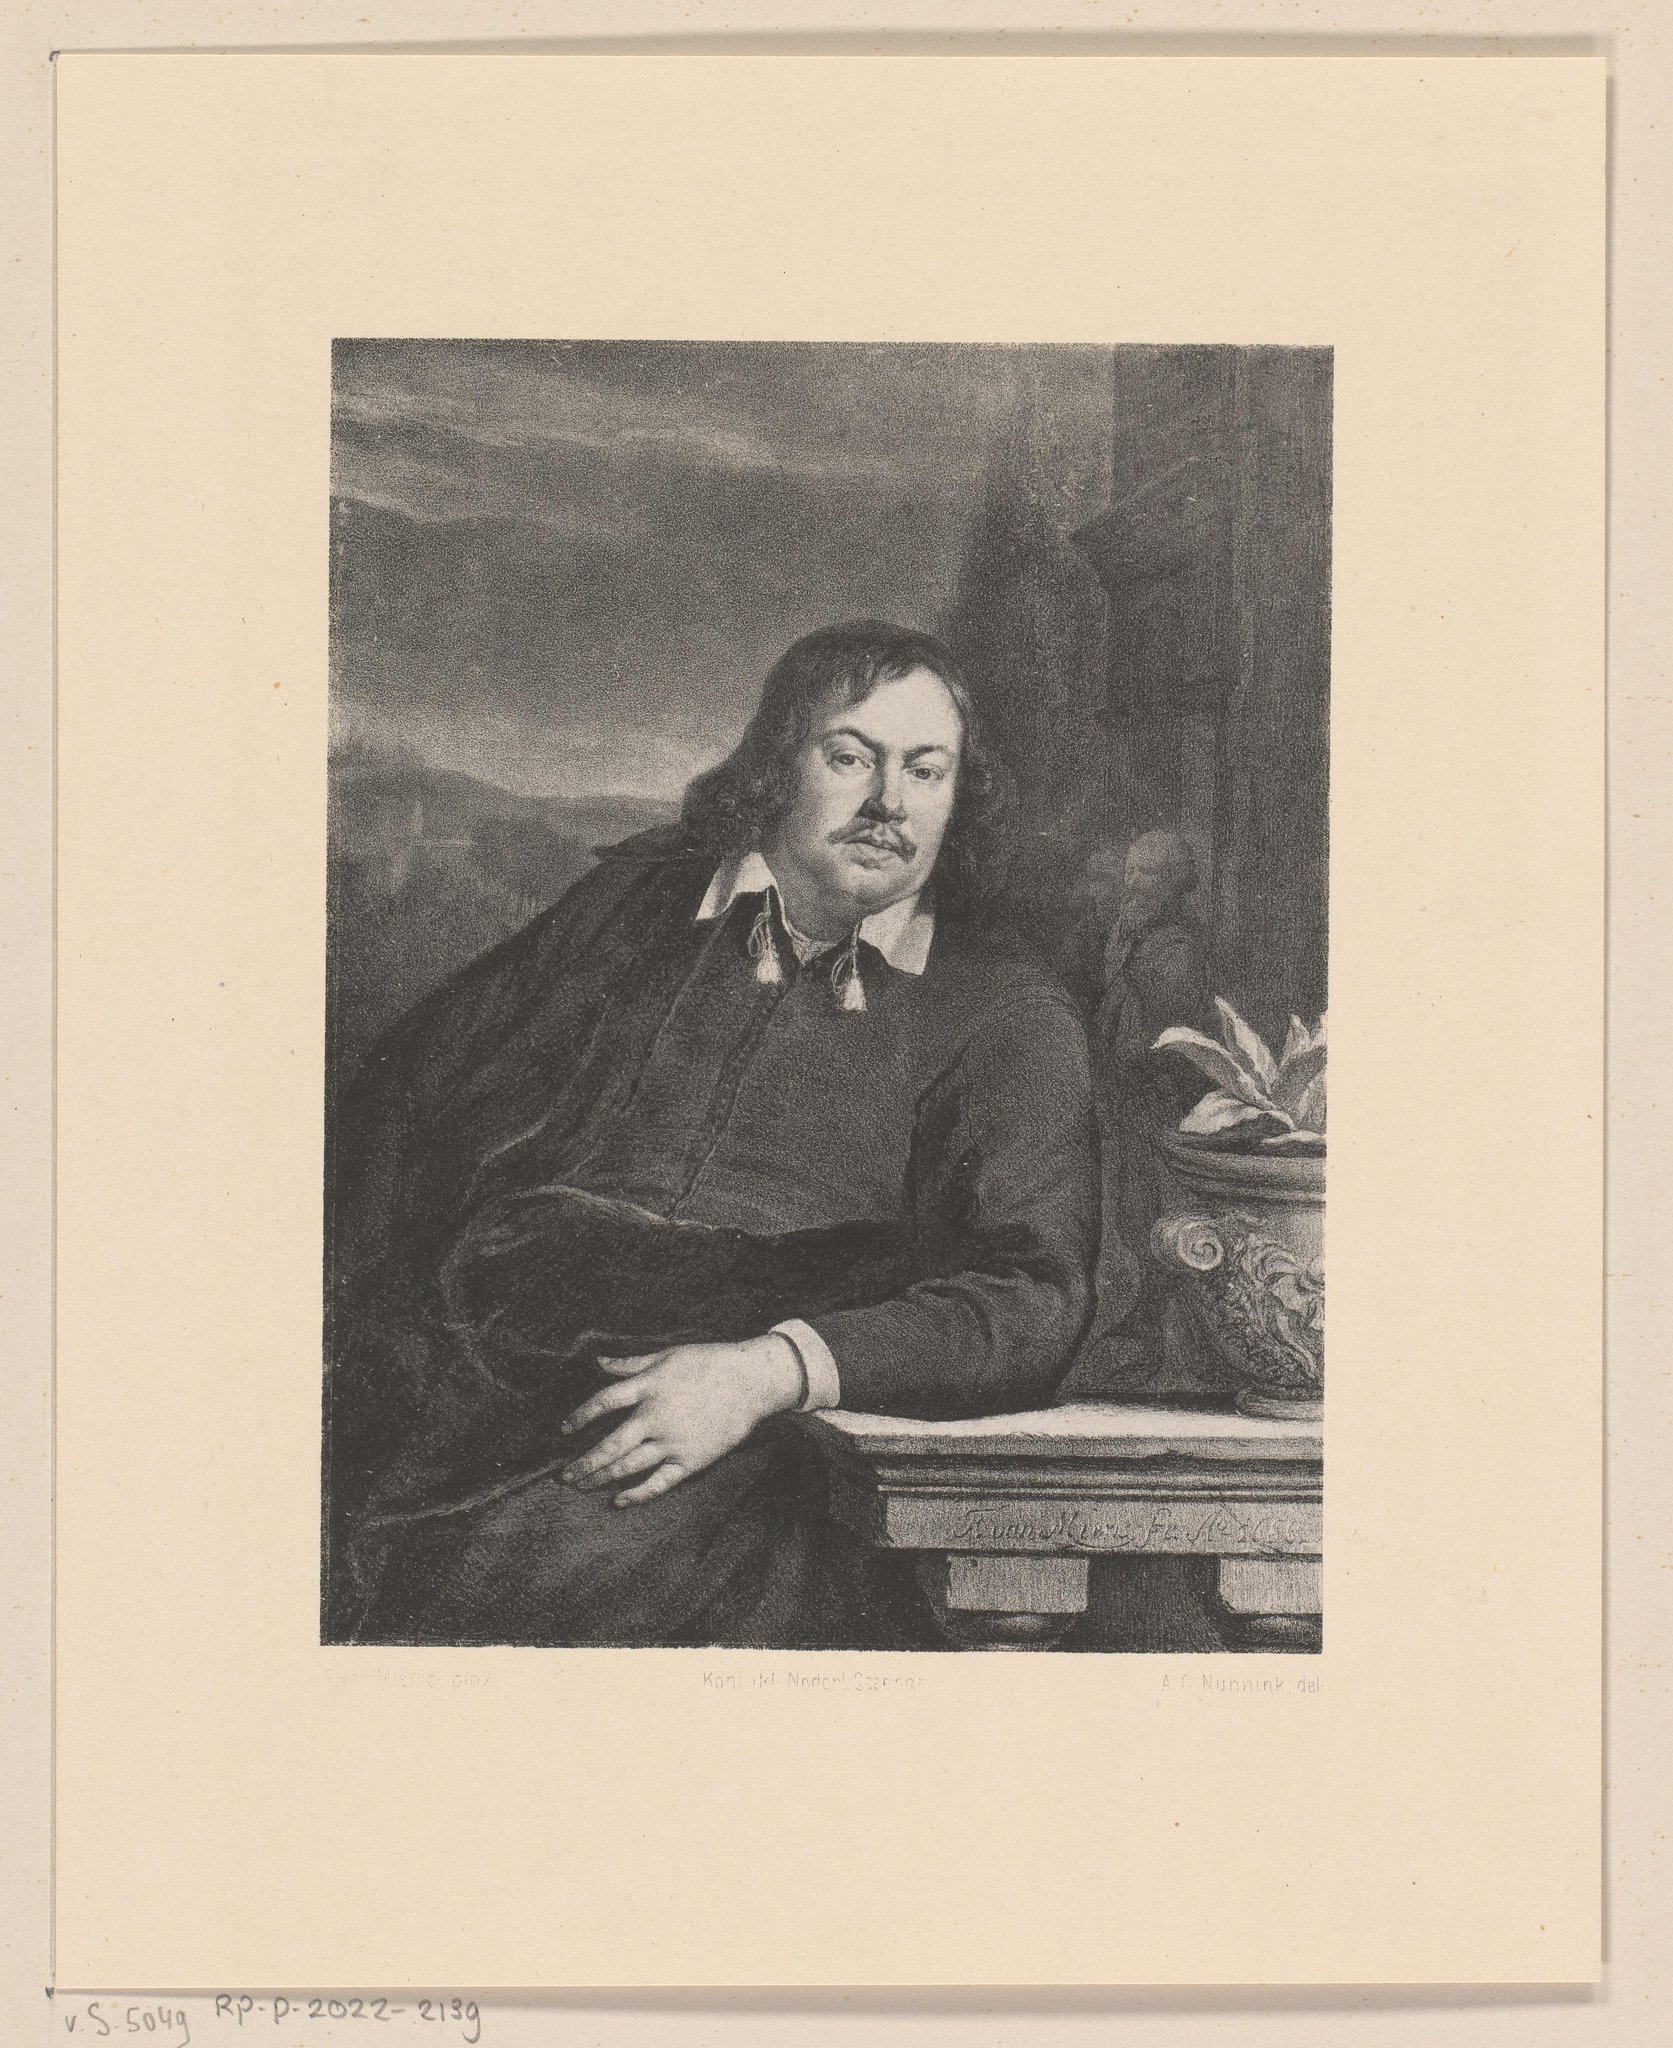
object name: print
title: Portret van Florentius Schuyl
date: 1867-1874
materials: paper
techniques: lithograph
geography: the hague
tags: botany (+ portrait of scholar, scientist), historical persons, physician, doctor